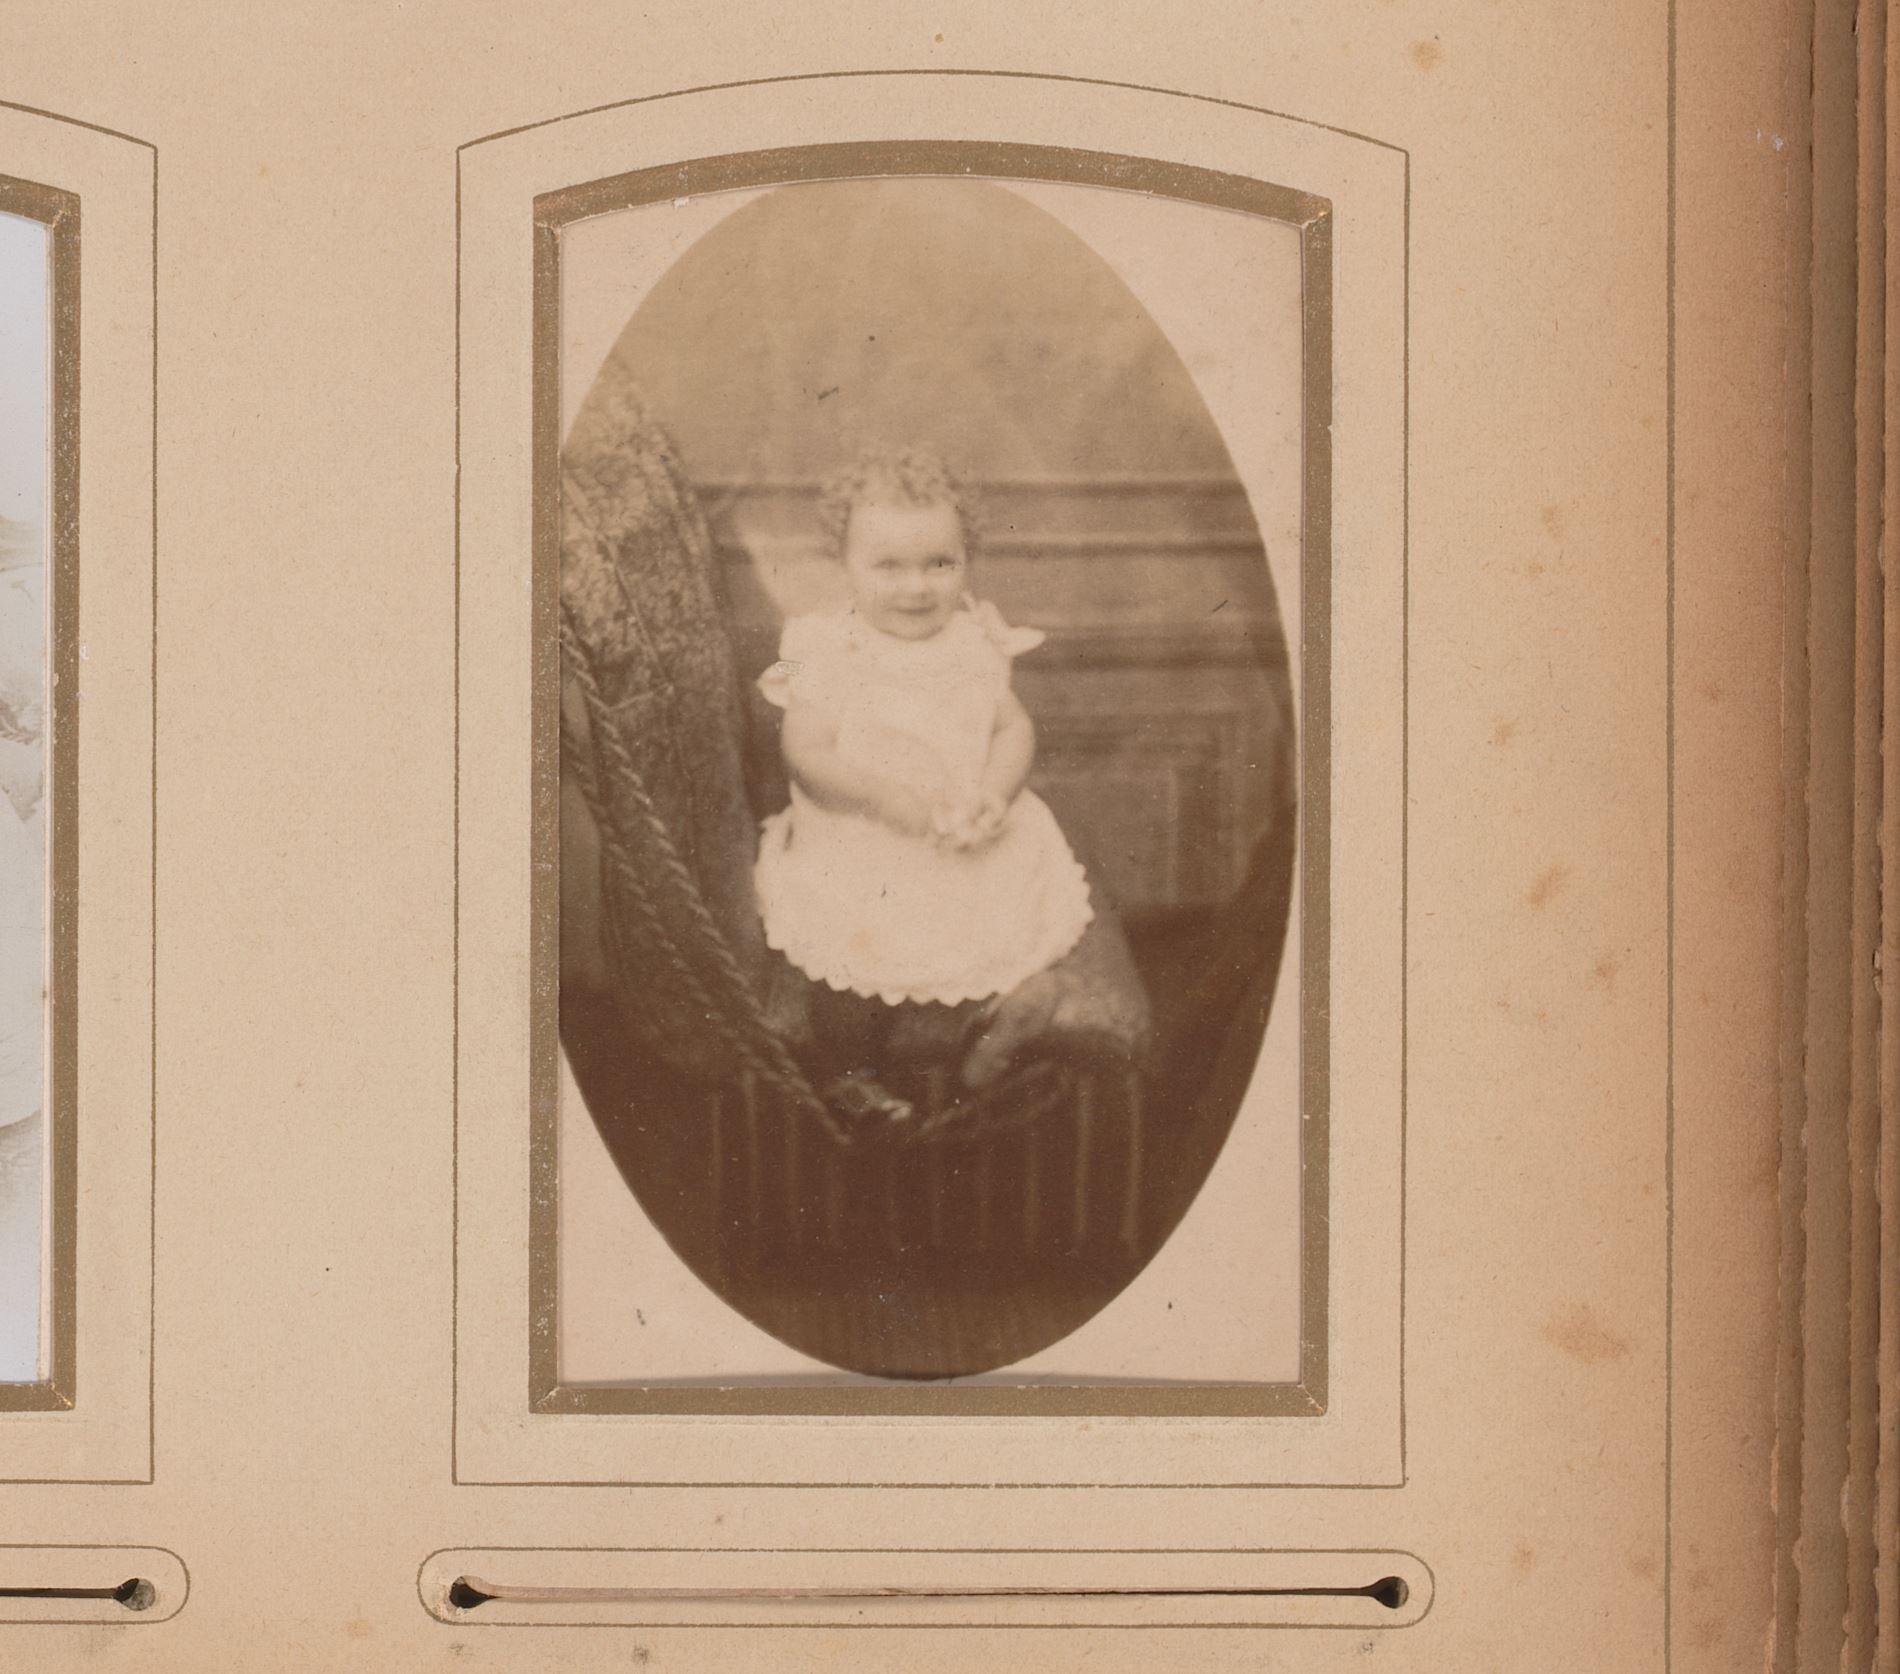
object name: photograph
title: Portret van een zittend meisje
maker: Anonymous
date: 1860-1900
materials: cardboard, photographic support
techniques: albumen print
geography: netherlands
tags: sitting figure - aa - female human figure, historical persons - bb - woman, toddler (female)